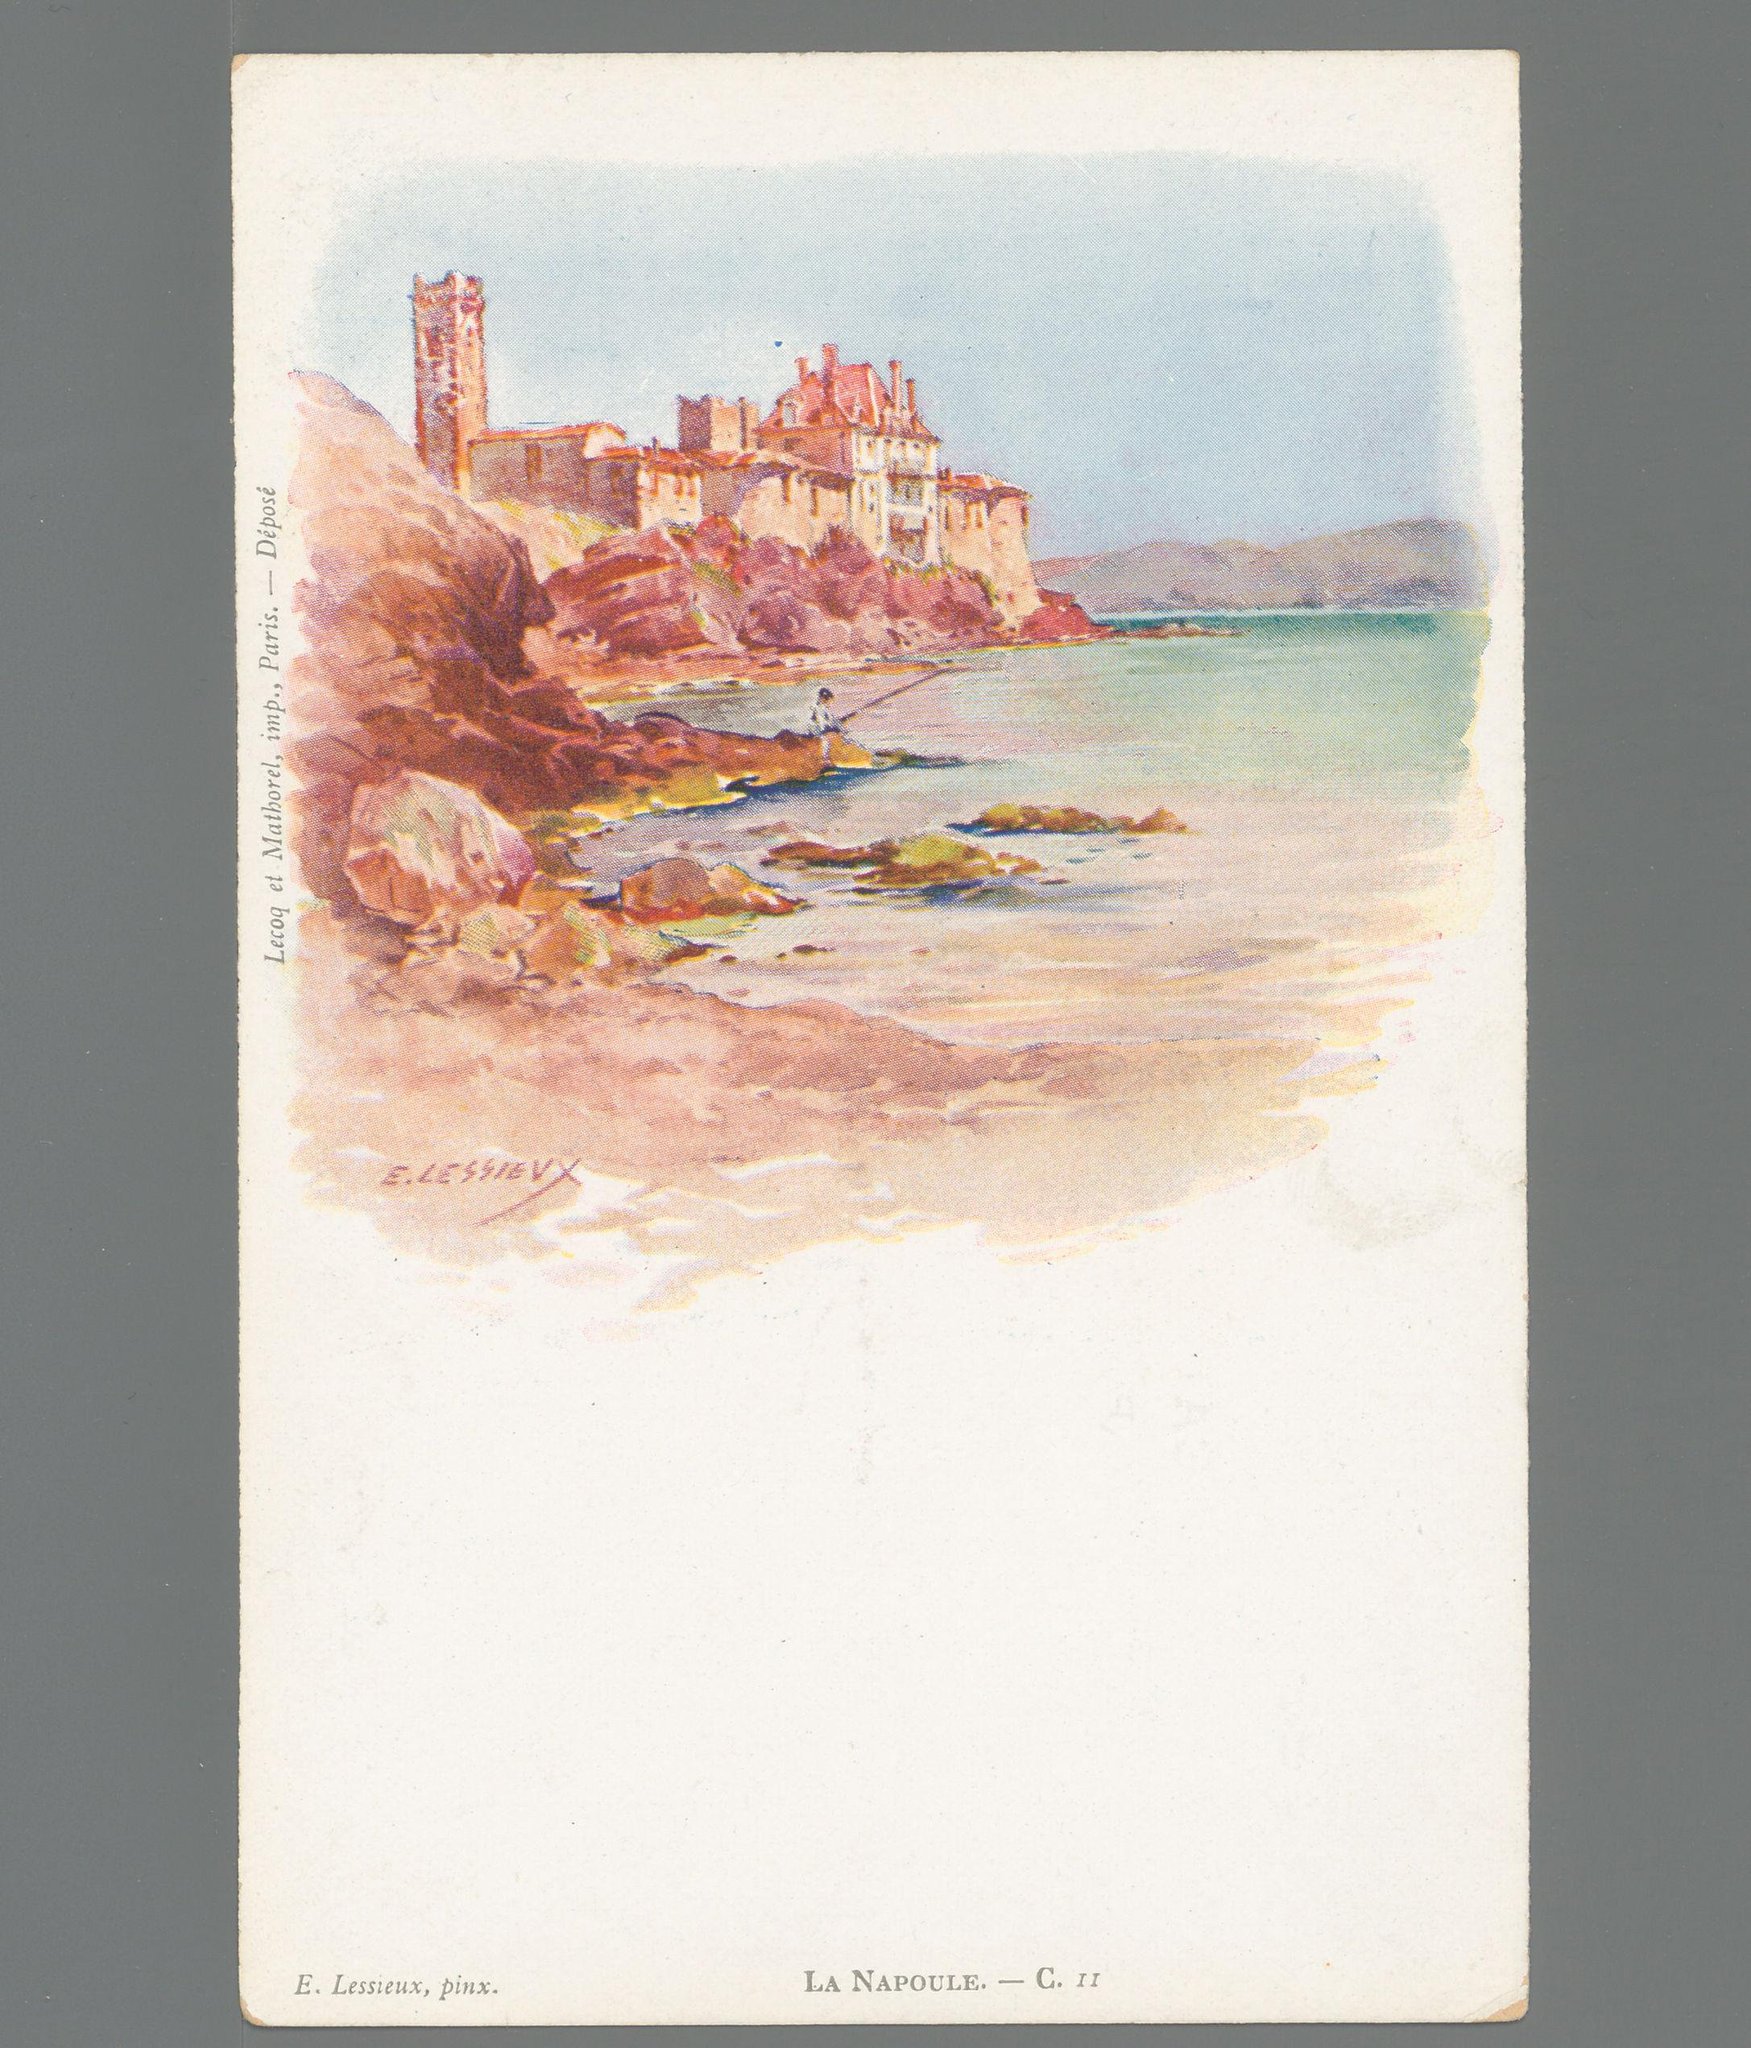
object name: photomechanical print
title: La Napoule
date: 1892-1904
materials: cardboard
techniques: writing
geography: paris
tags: rocky coast, sea (seascape), prospect of city, town panorama, silhouette of city